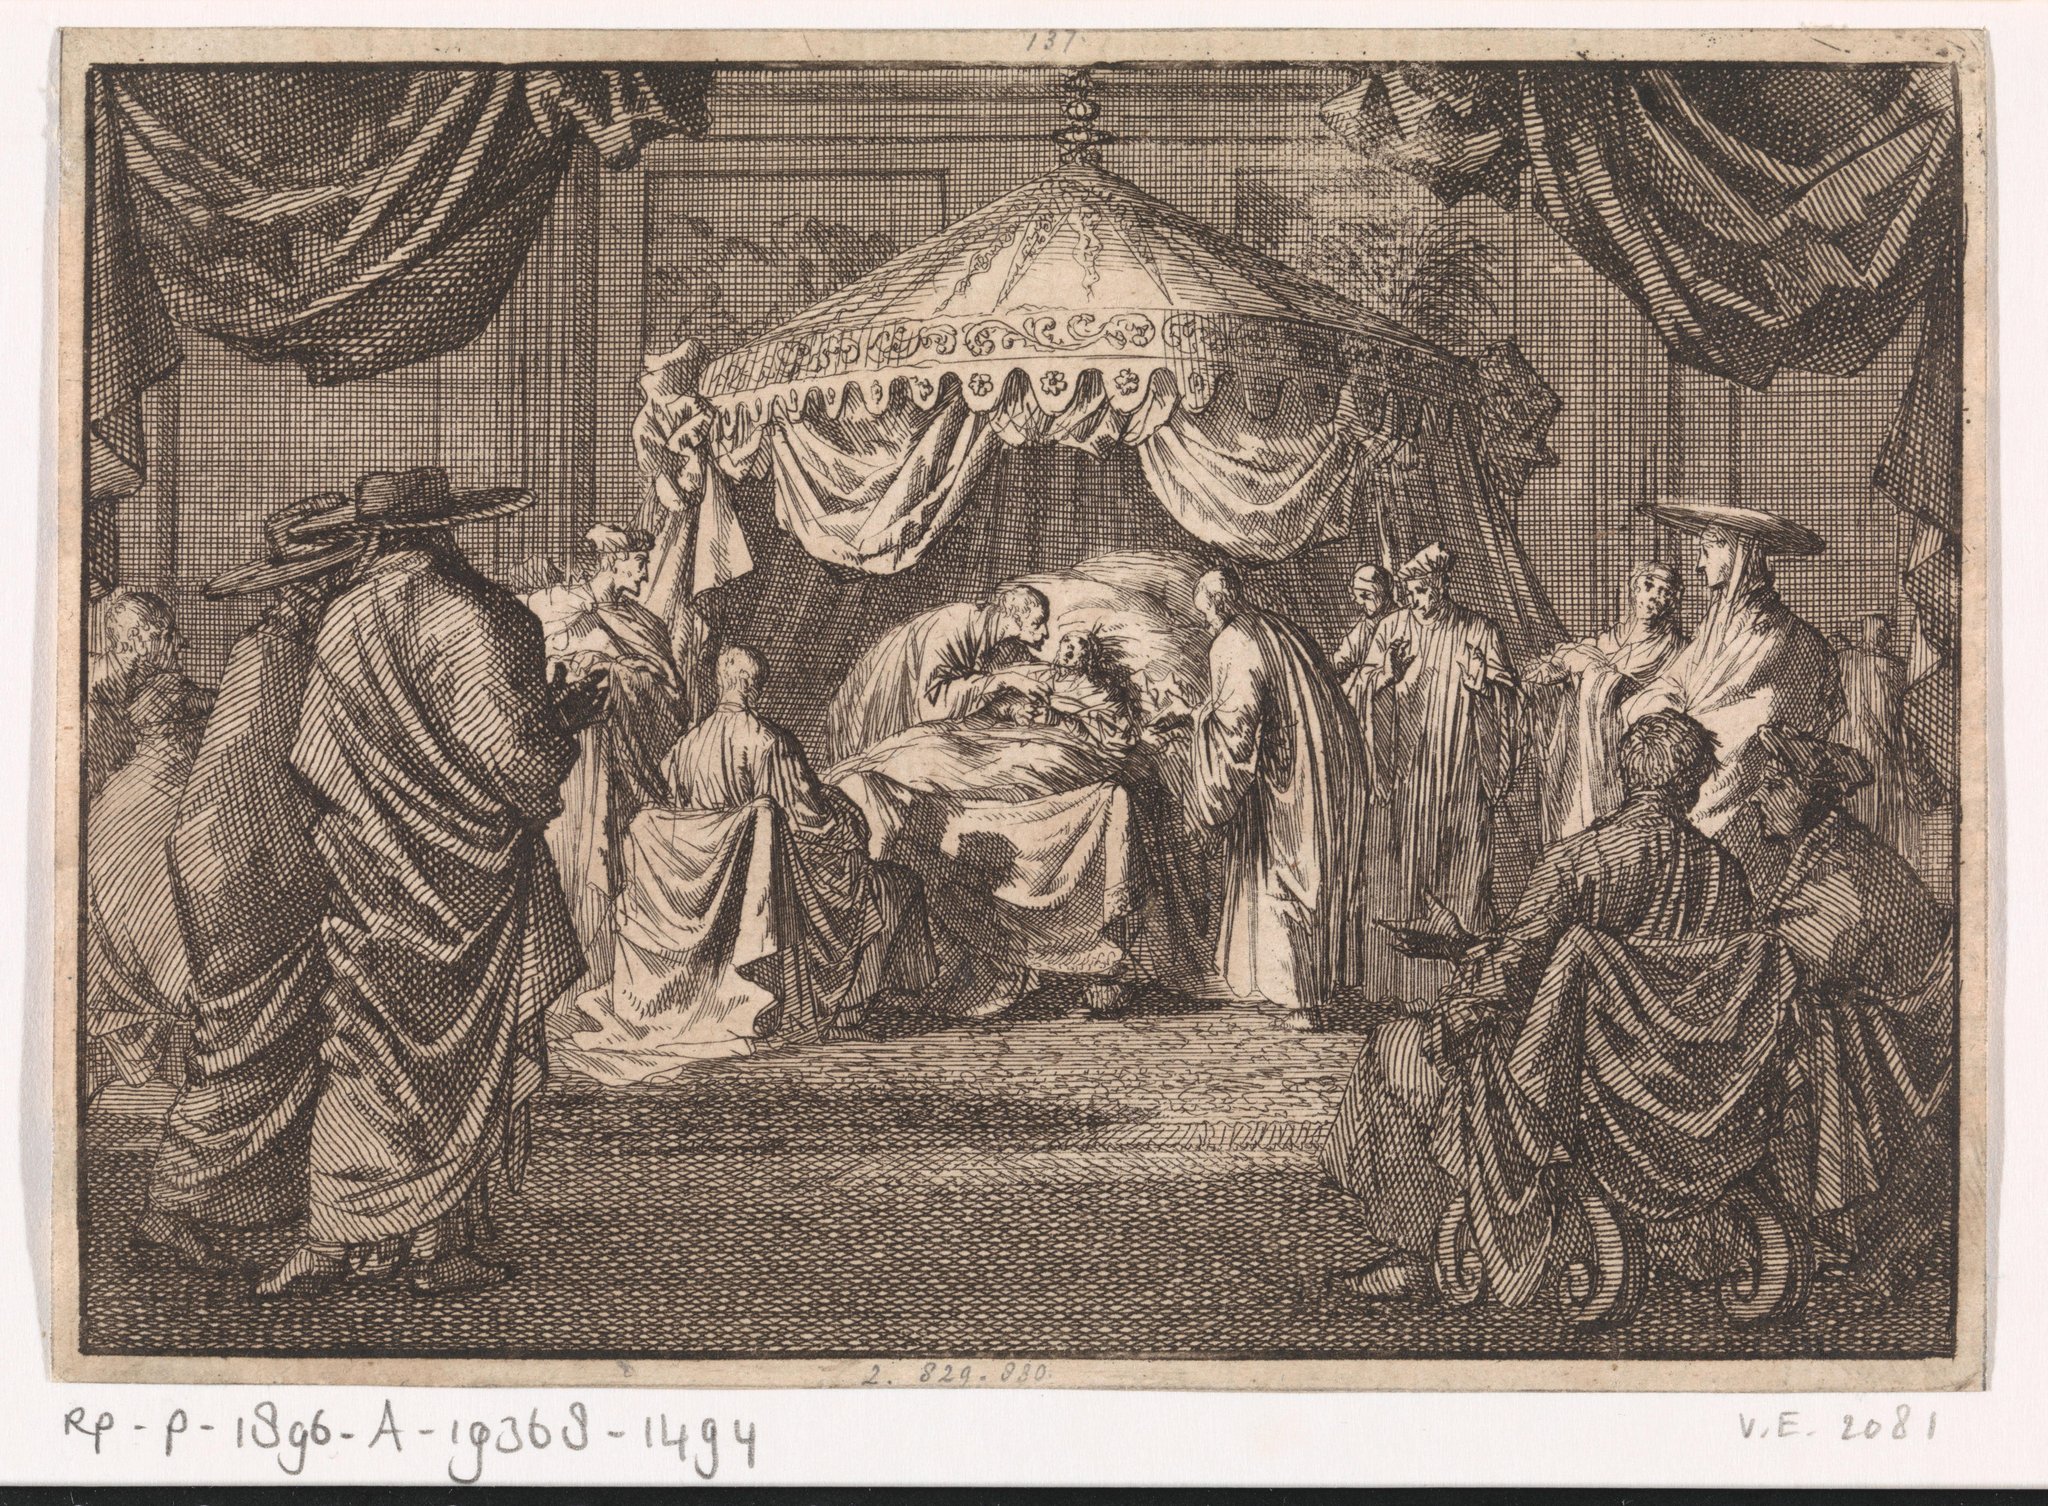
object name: print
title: Sterfbed van paus Alexander VII, 1667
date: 1698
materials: paper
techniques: etching, letterpress printing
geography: leiden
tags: alexander vii, deathbed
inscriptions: collector's mark: Lugt 2228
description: Illustratie uit: Gottfried, Johann Ludwig. Historische kronyck; vervattende een (...) beschrijvingh der aldergedenckwaerdigste geschiedenissen des weerelds, van den aenvangh der scheppingh tot (...) 1576 (2 delen). Leiden: Pieter van der Aa, 1698, dl. II, p. 829.